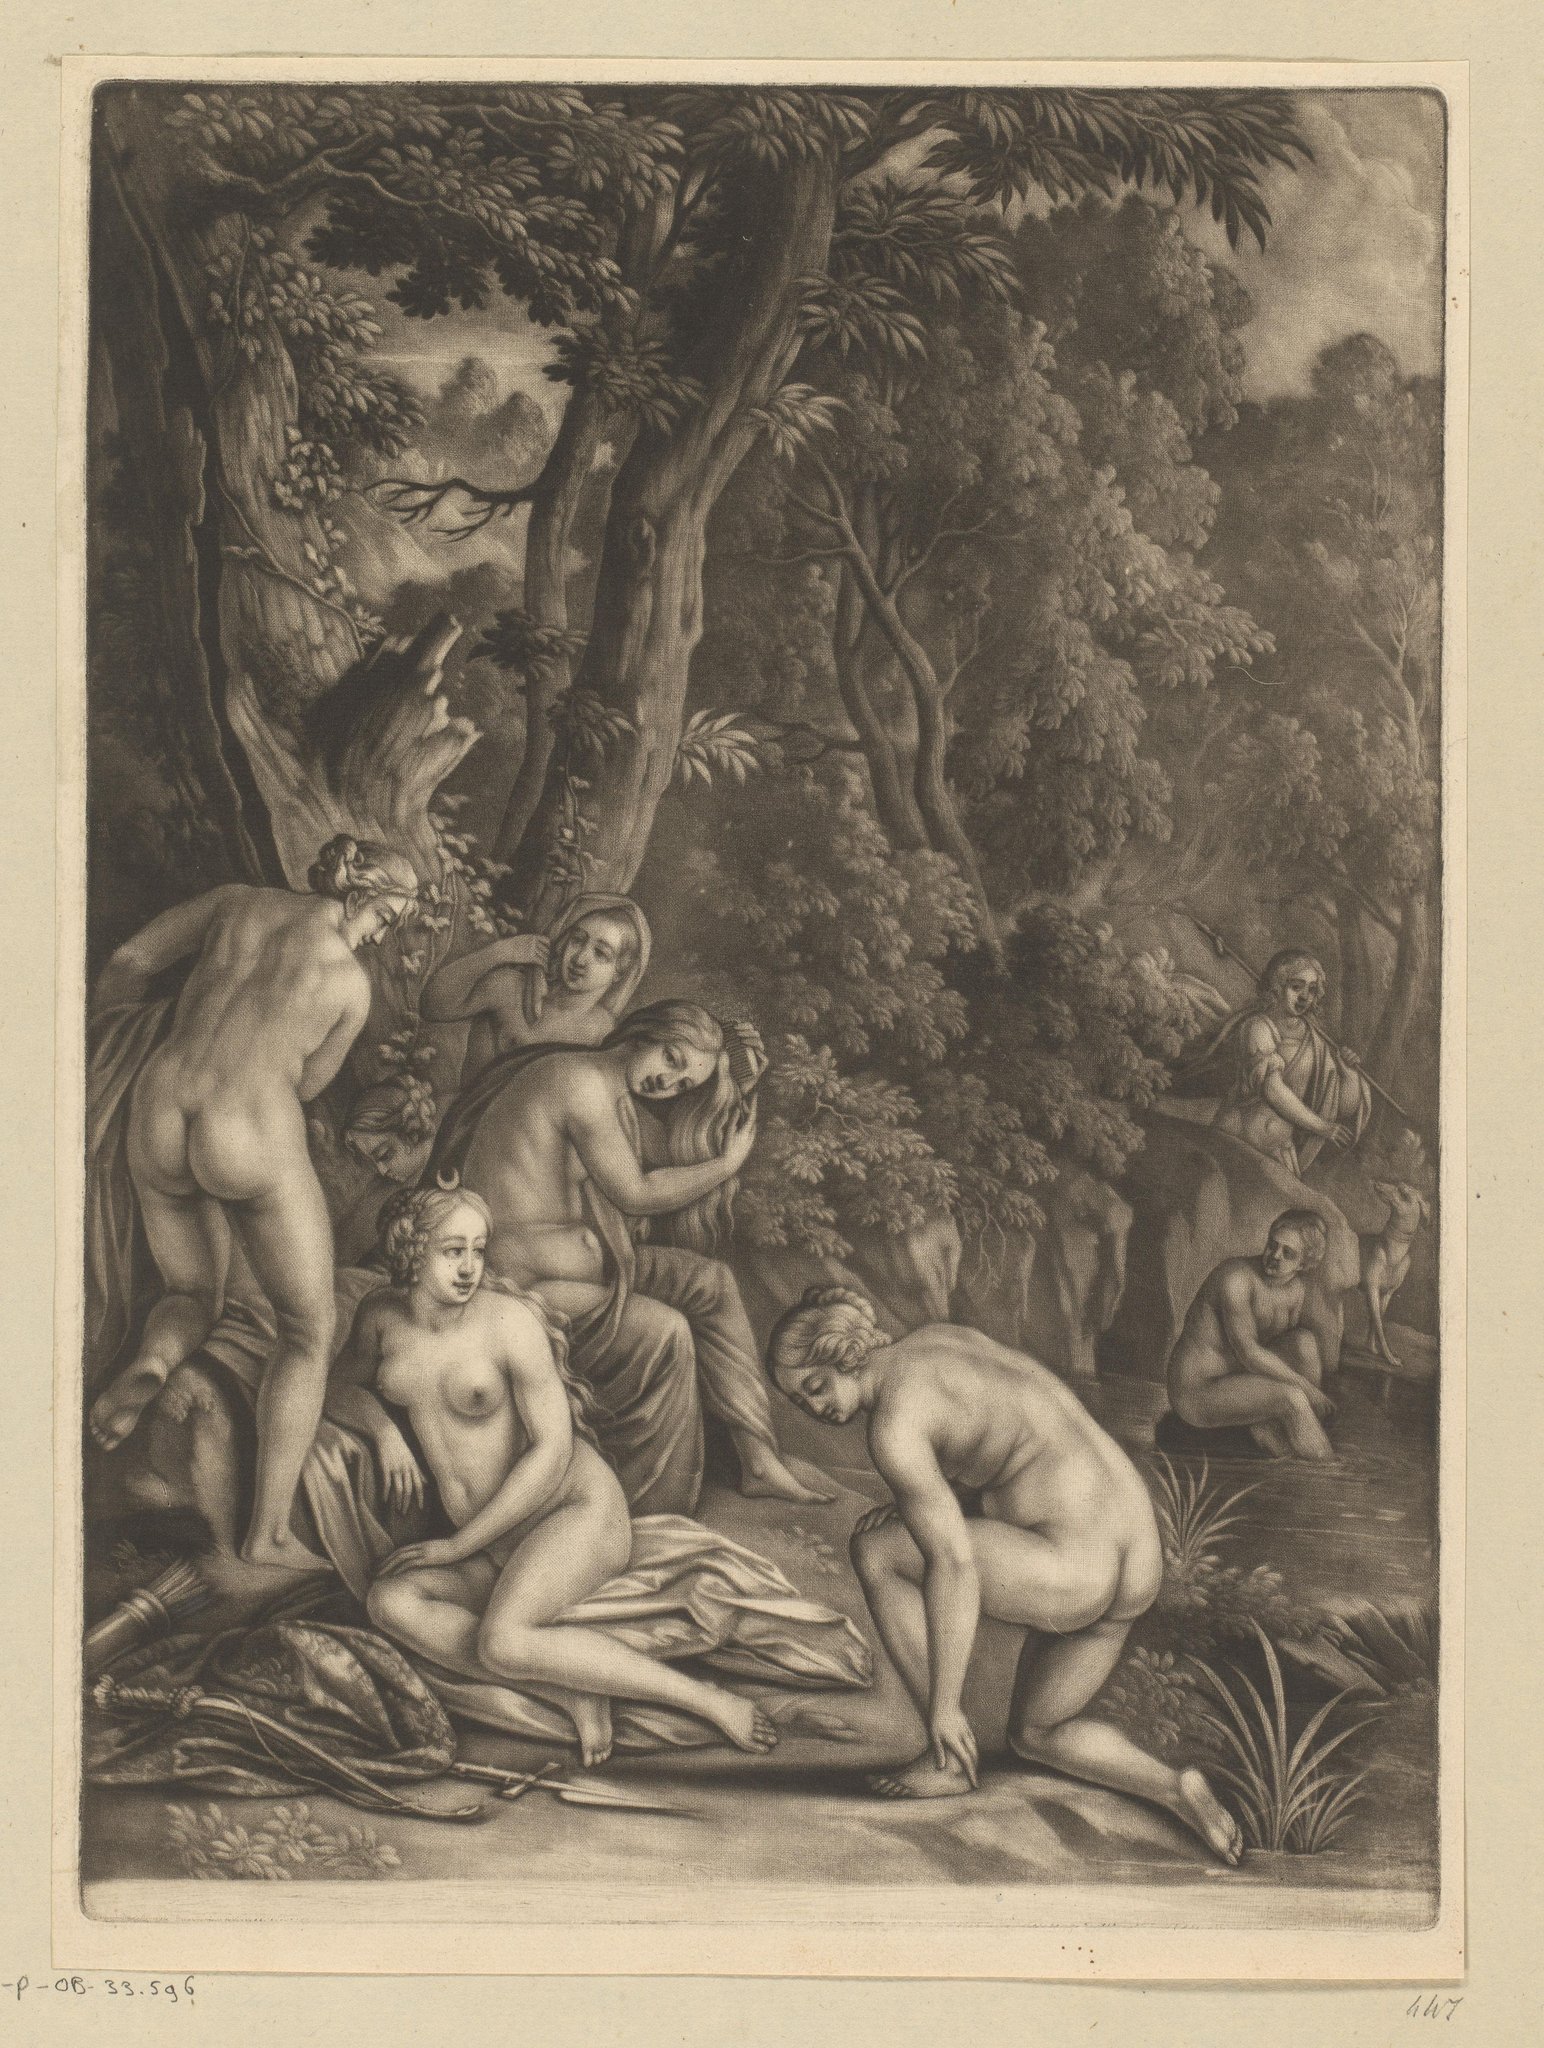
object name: print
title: Actaeon en Diana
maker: bernard lens (ii)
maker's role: print maker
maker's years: 1659-1725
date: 1680-1690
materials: paper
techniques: mezzotint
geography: england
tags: actaeon changed into a stag: as punishment for seeing her bathe, diana changes actaeon, the hunter, into a stag (ovid, metamorphoses iii 193), diana bathing with her nymphs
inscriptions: collector's mark: Lugt 240